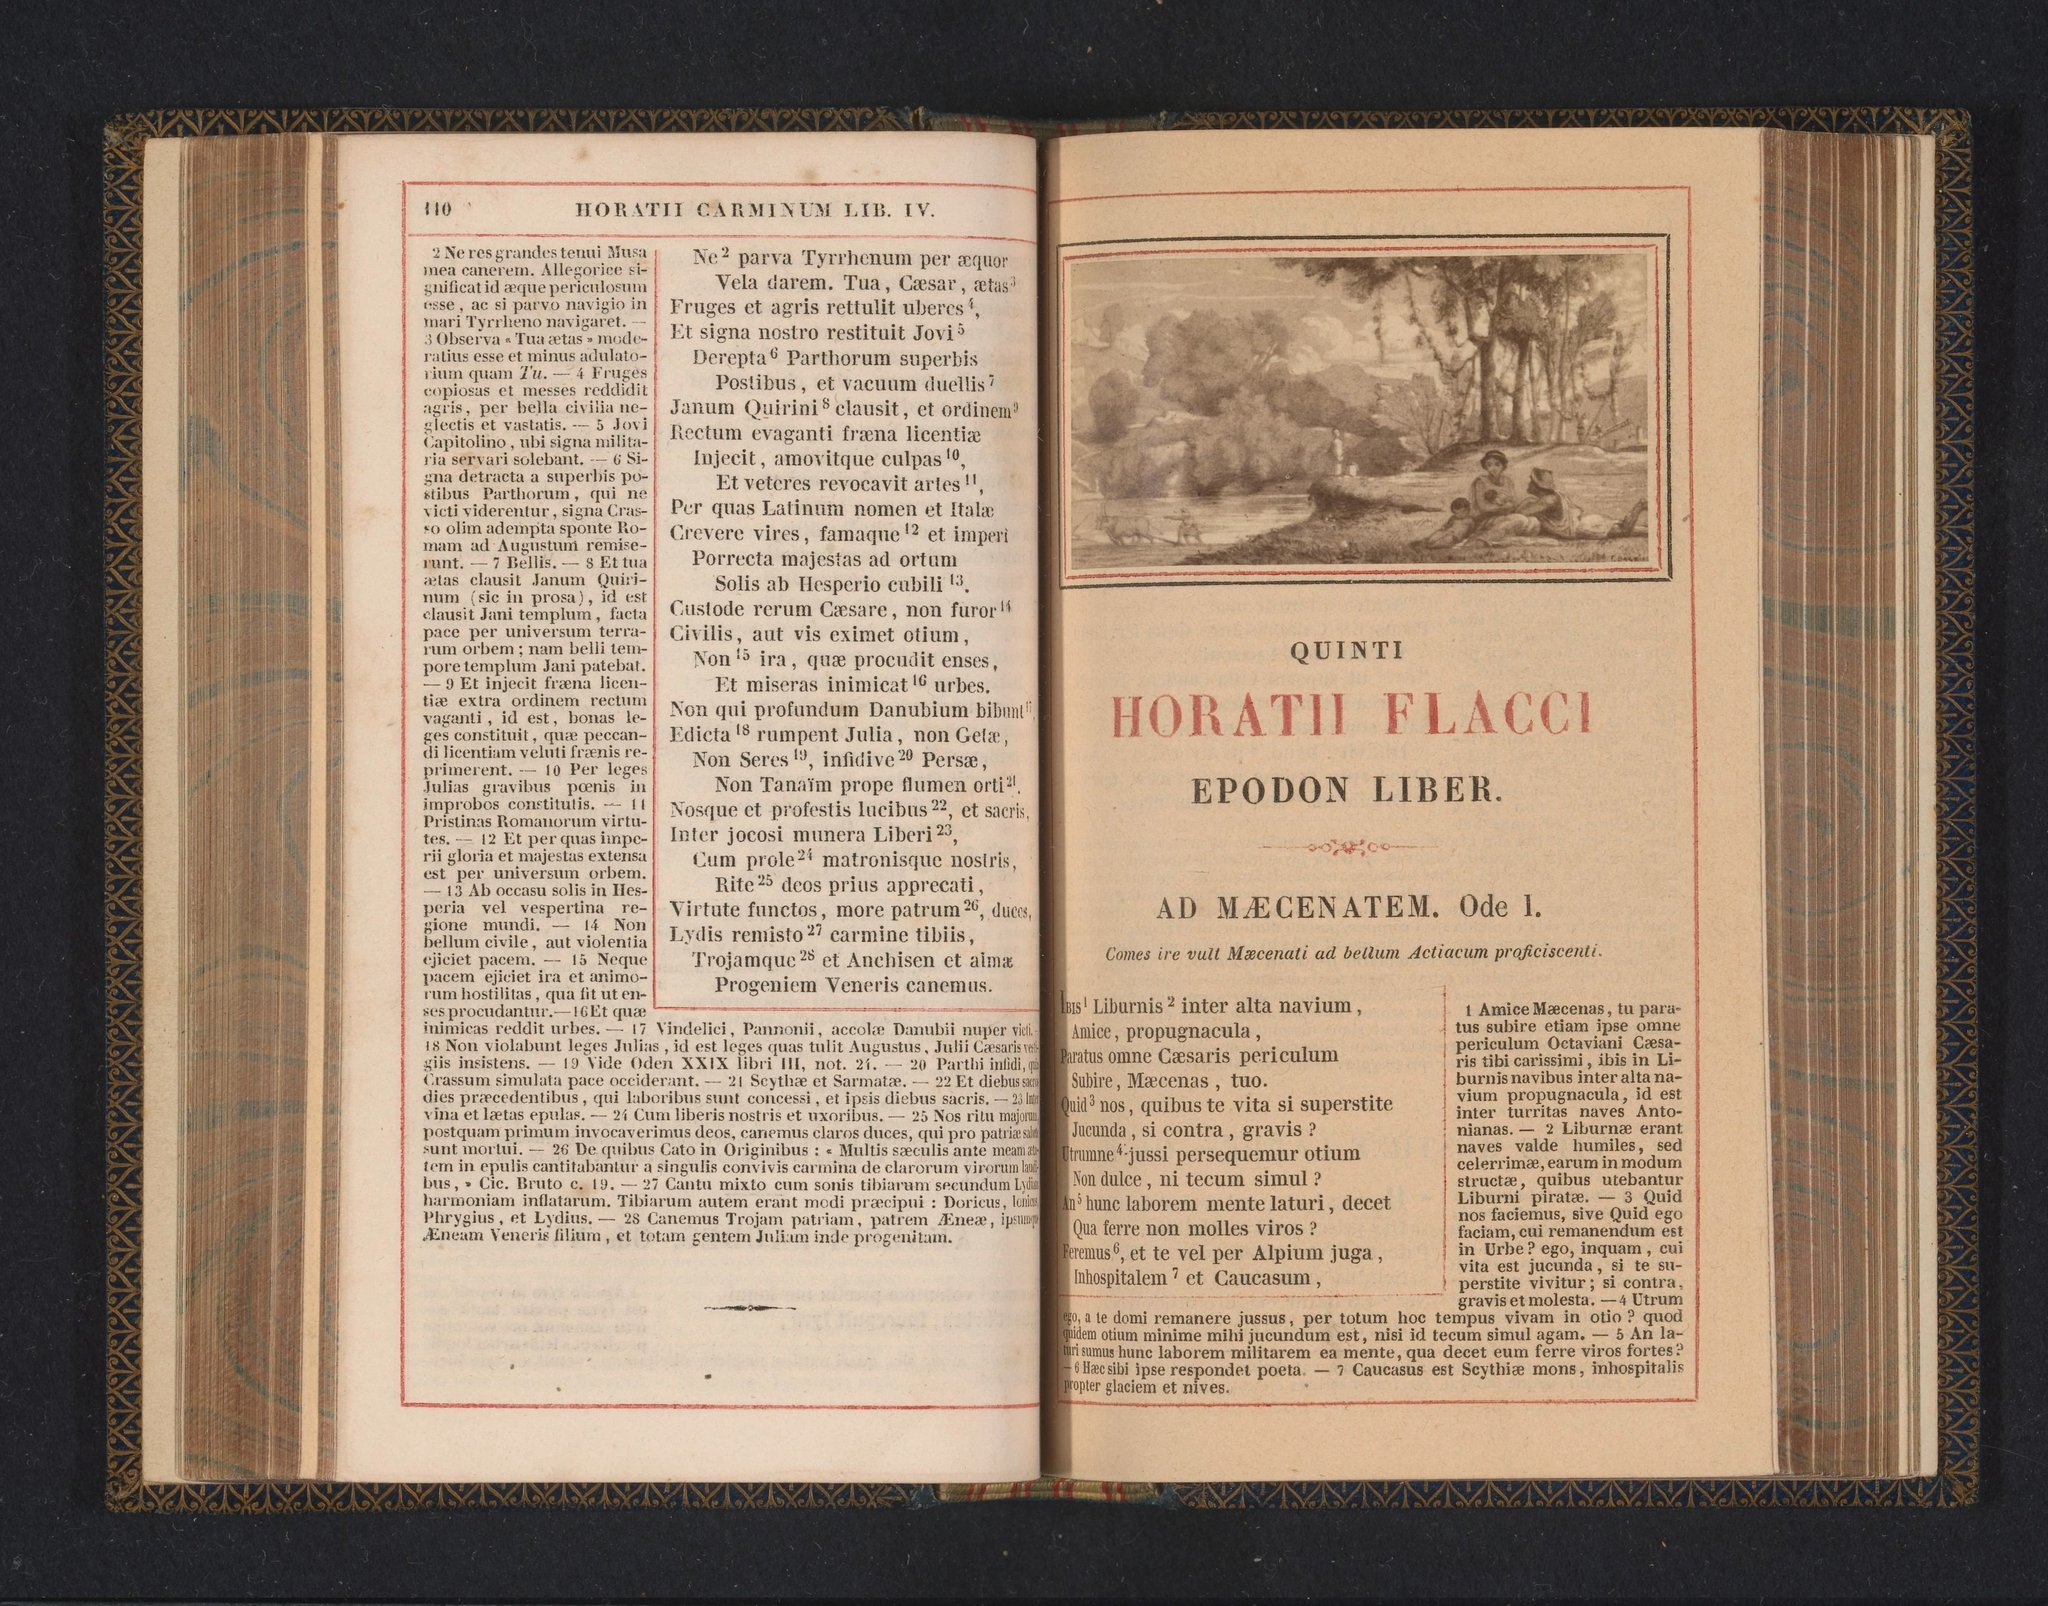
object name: photograph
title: Fotoreproductie van een schilderij, voorstellende een zittend gezin voor een meer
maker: Anonymous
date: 1850-1855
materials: photographic support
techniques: albumen print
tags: lake, sitting on the ground